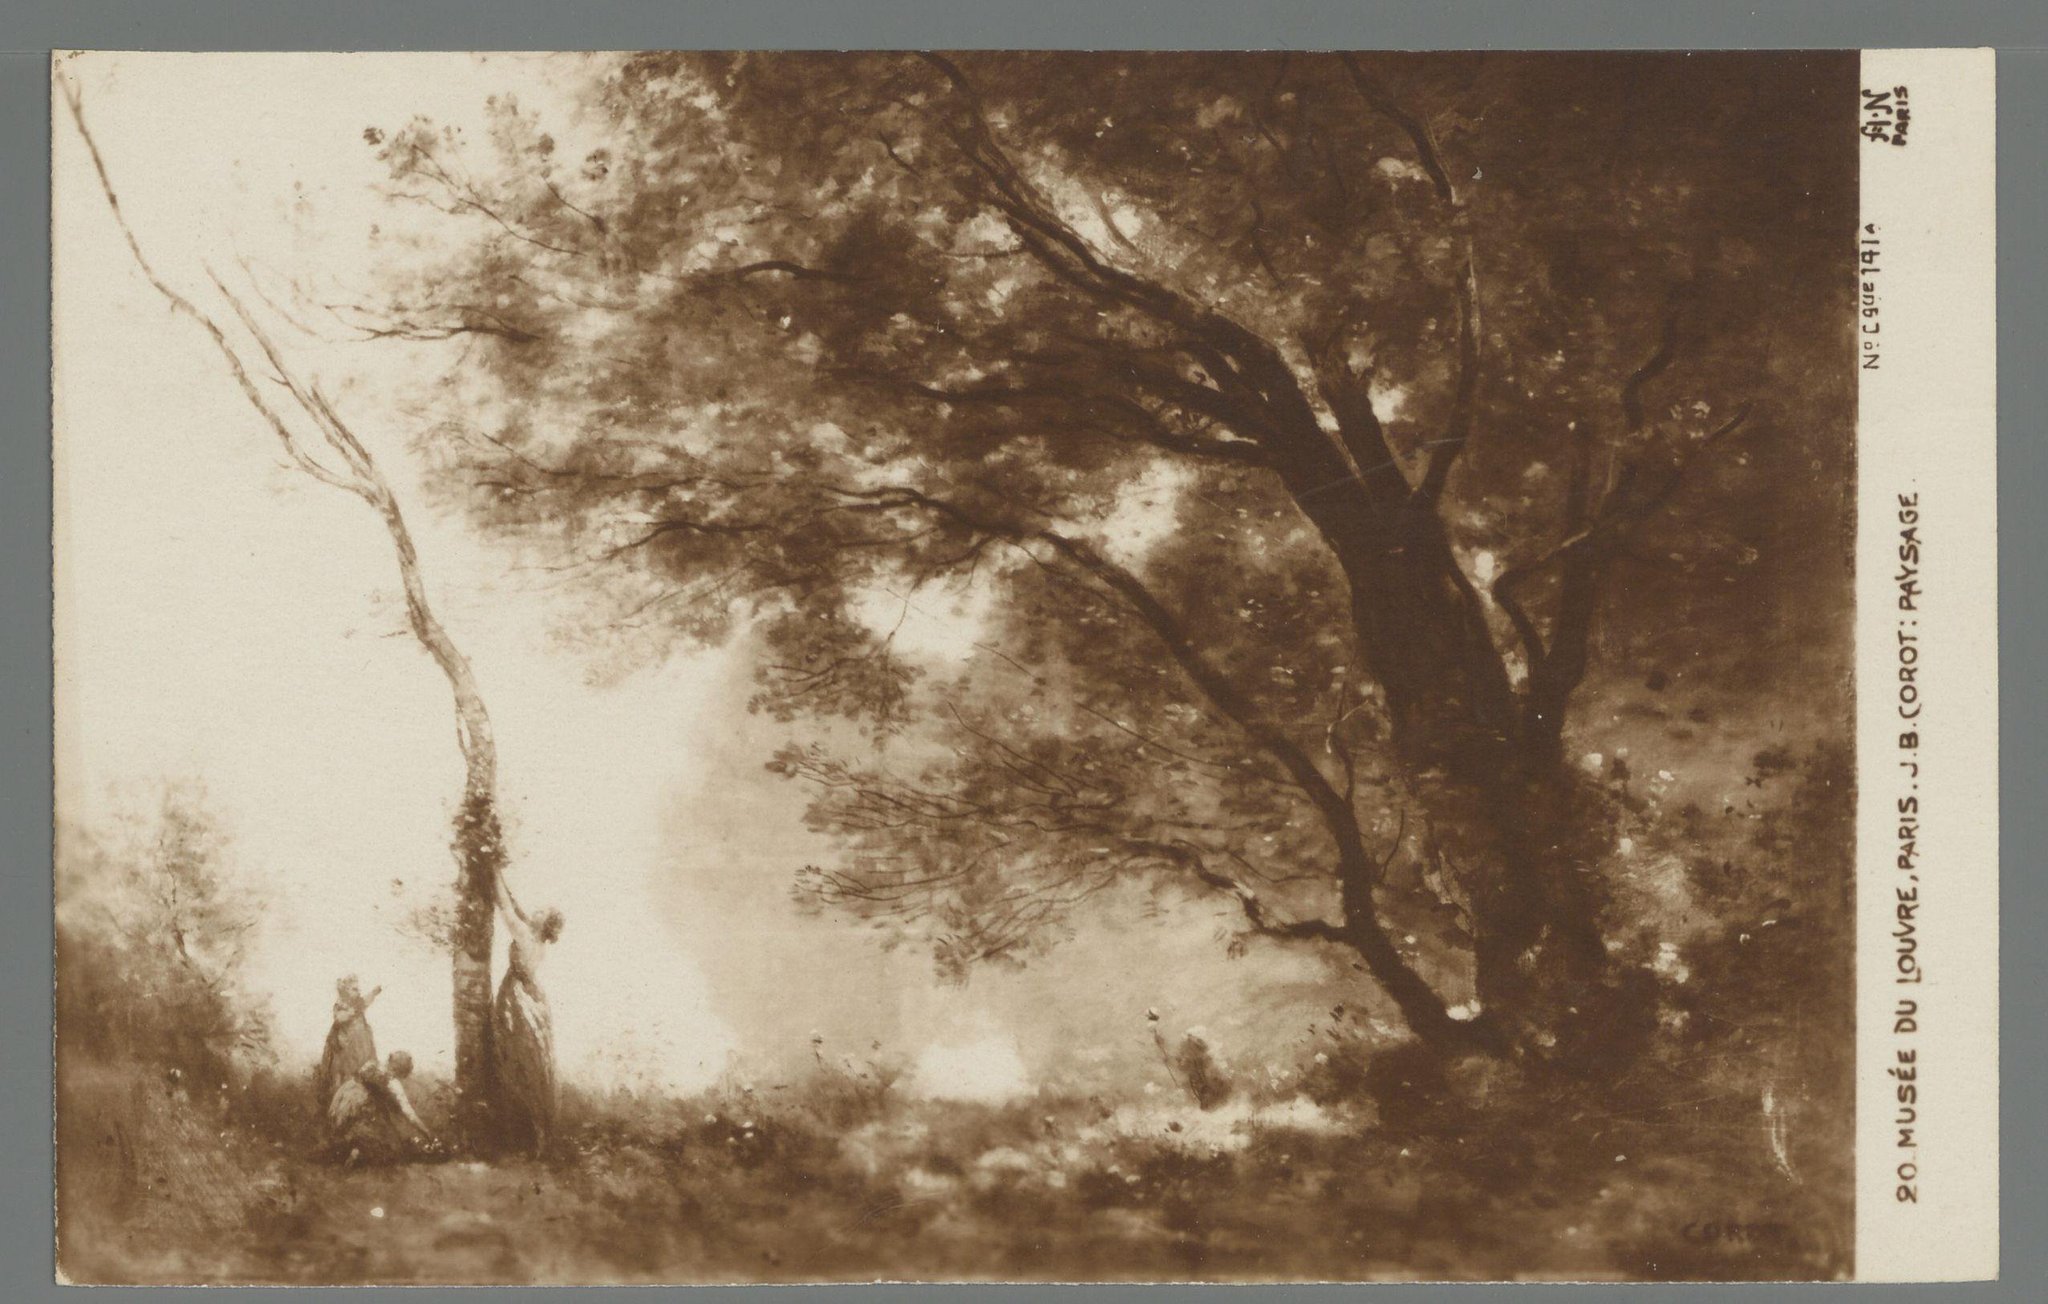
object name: photograph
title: Musée du Louvre, Paris. J.B. Corot: Paysage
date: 1910-1930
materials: photographic support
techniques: photography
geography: france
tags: permanent exhibition, museum, picture, painting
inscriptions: collector's mark: ‘AFE v S’